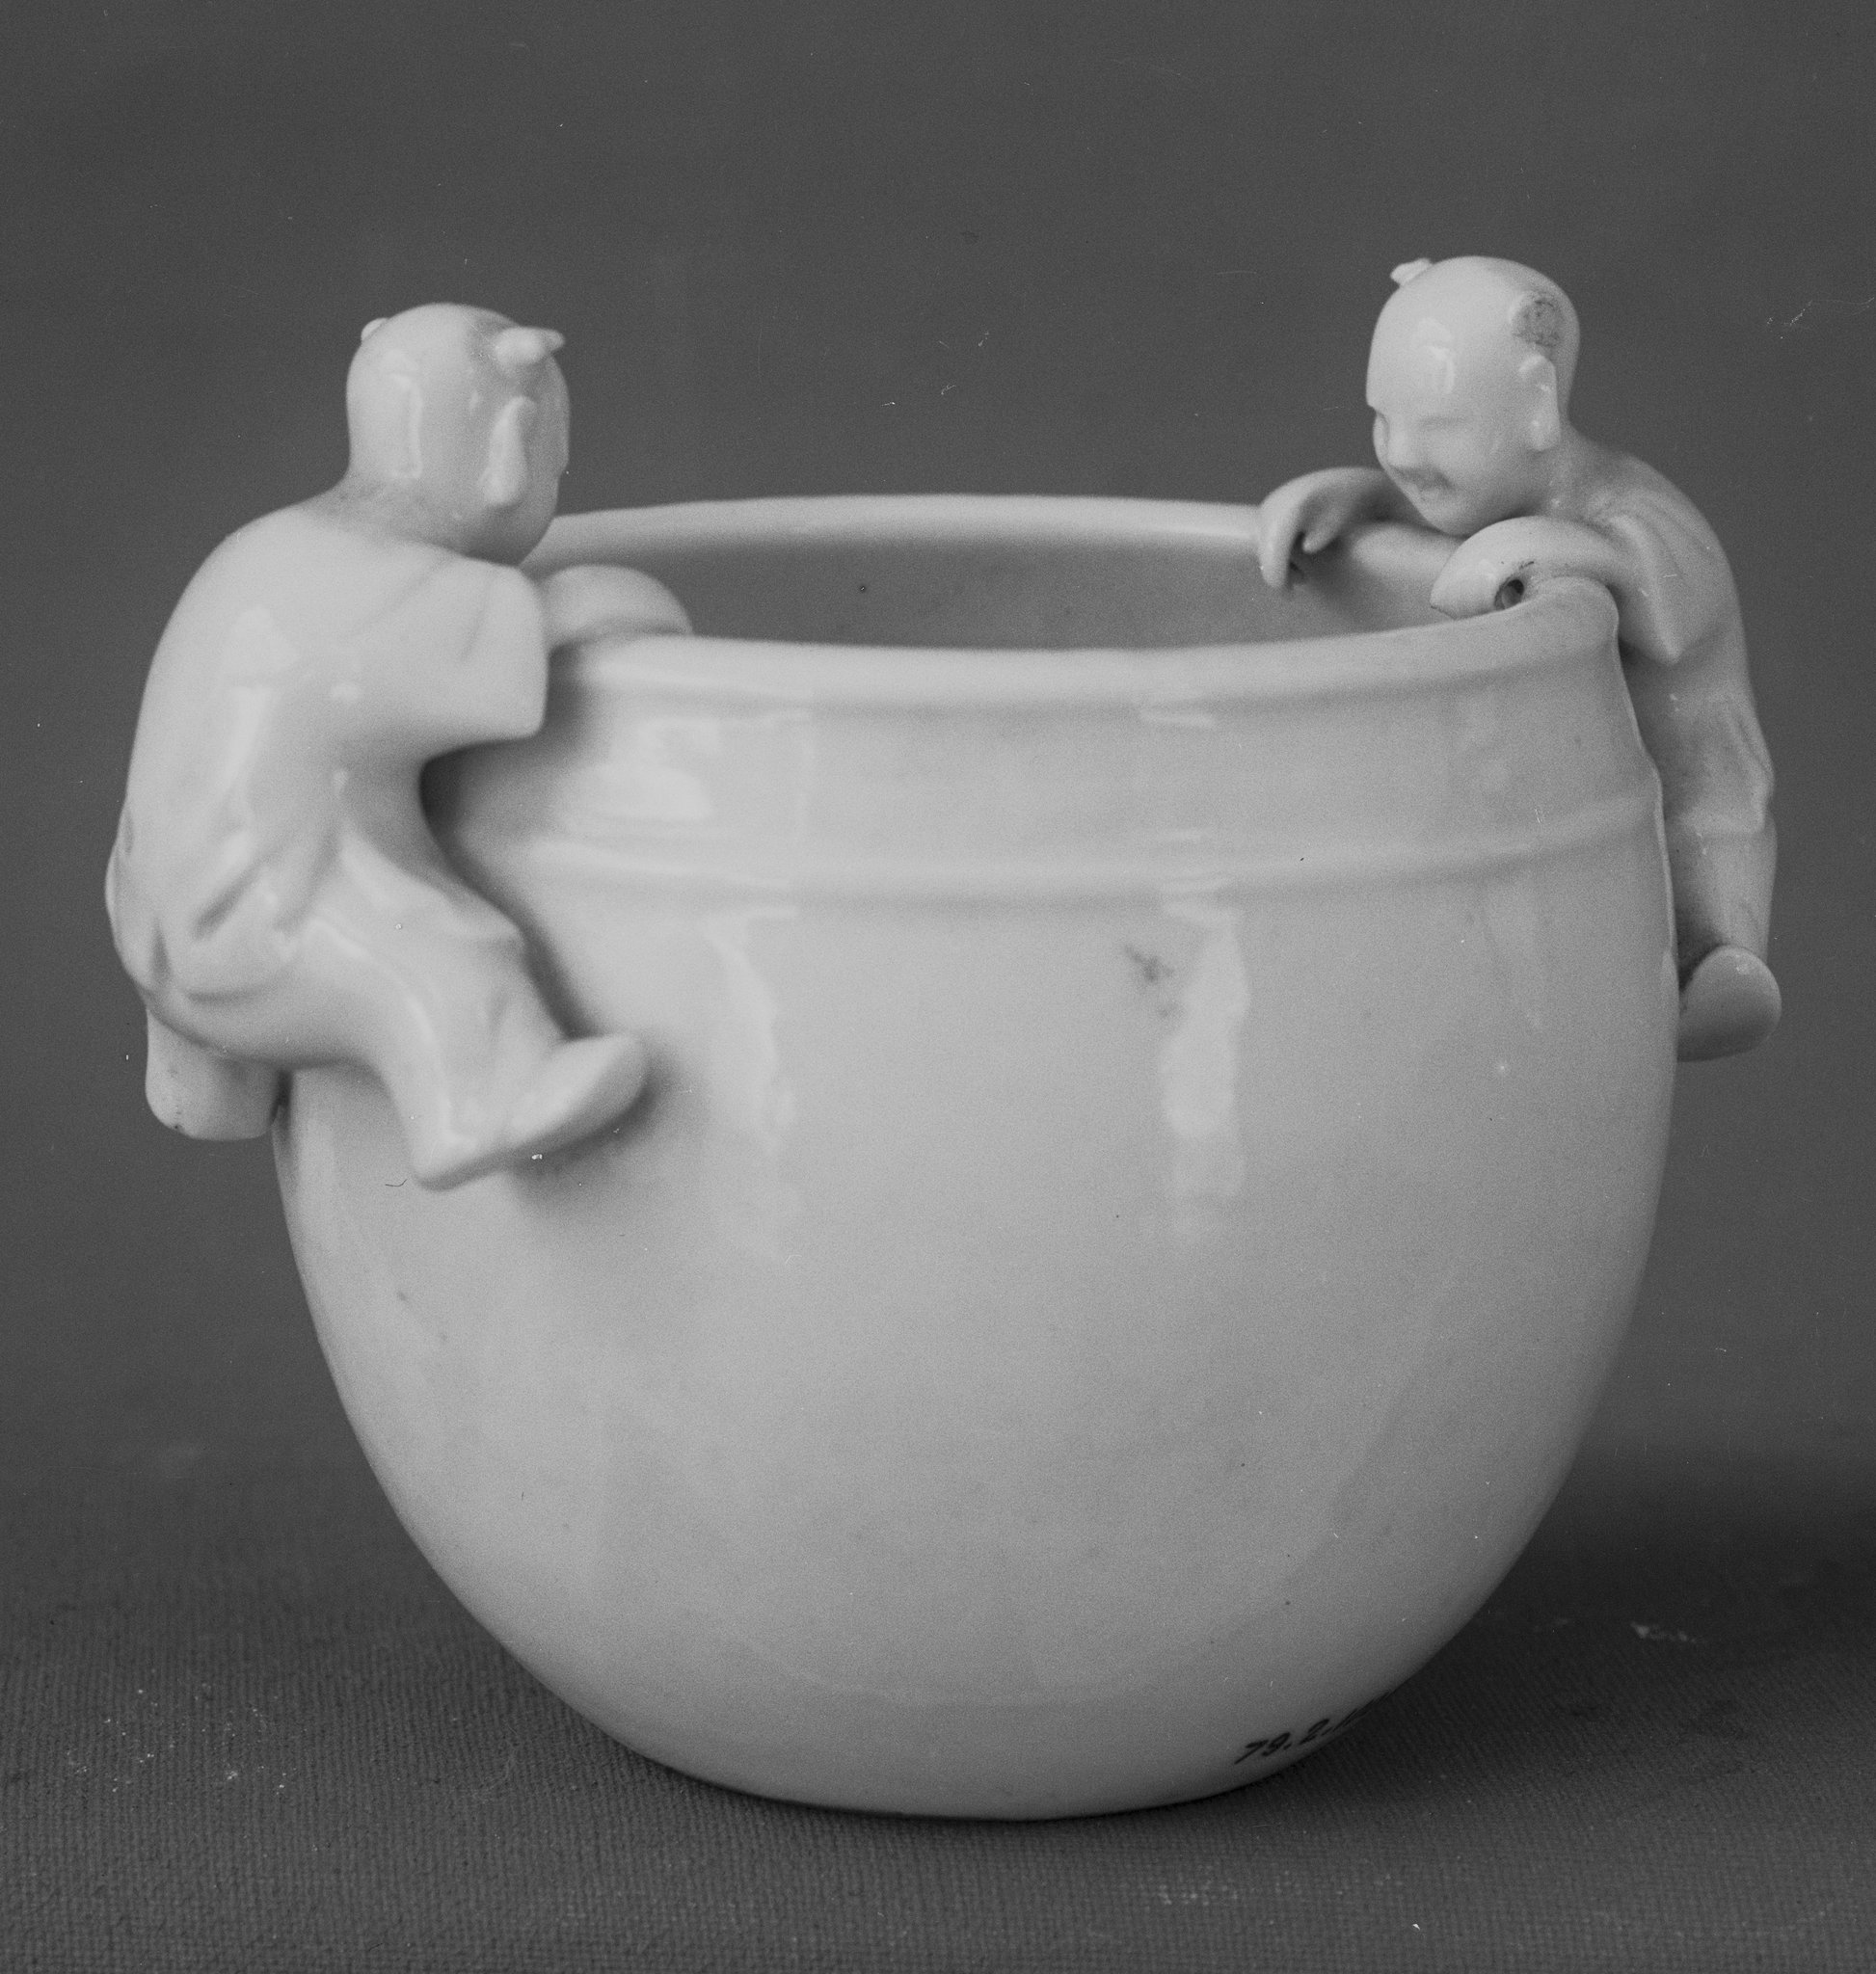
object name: water pot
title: Water Pot with Boys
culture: chinese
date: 1701-1800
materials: porcelain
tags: boys